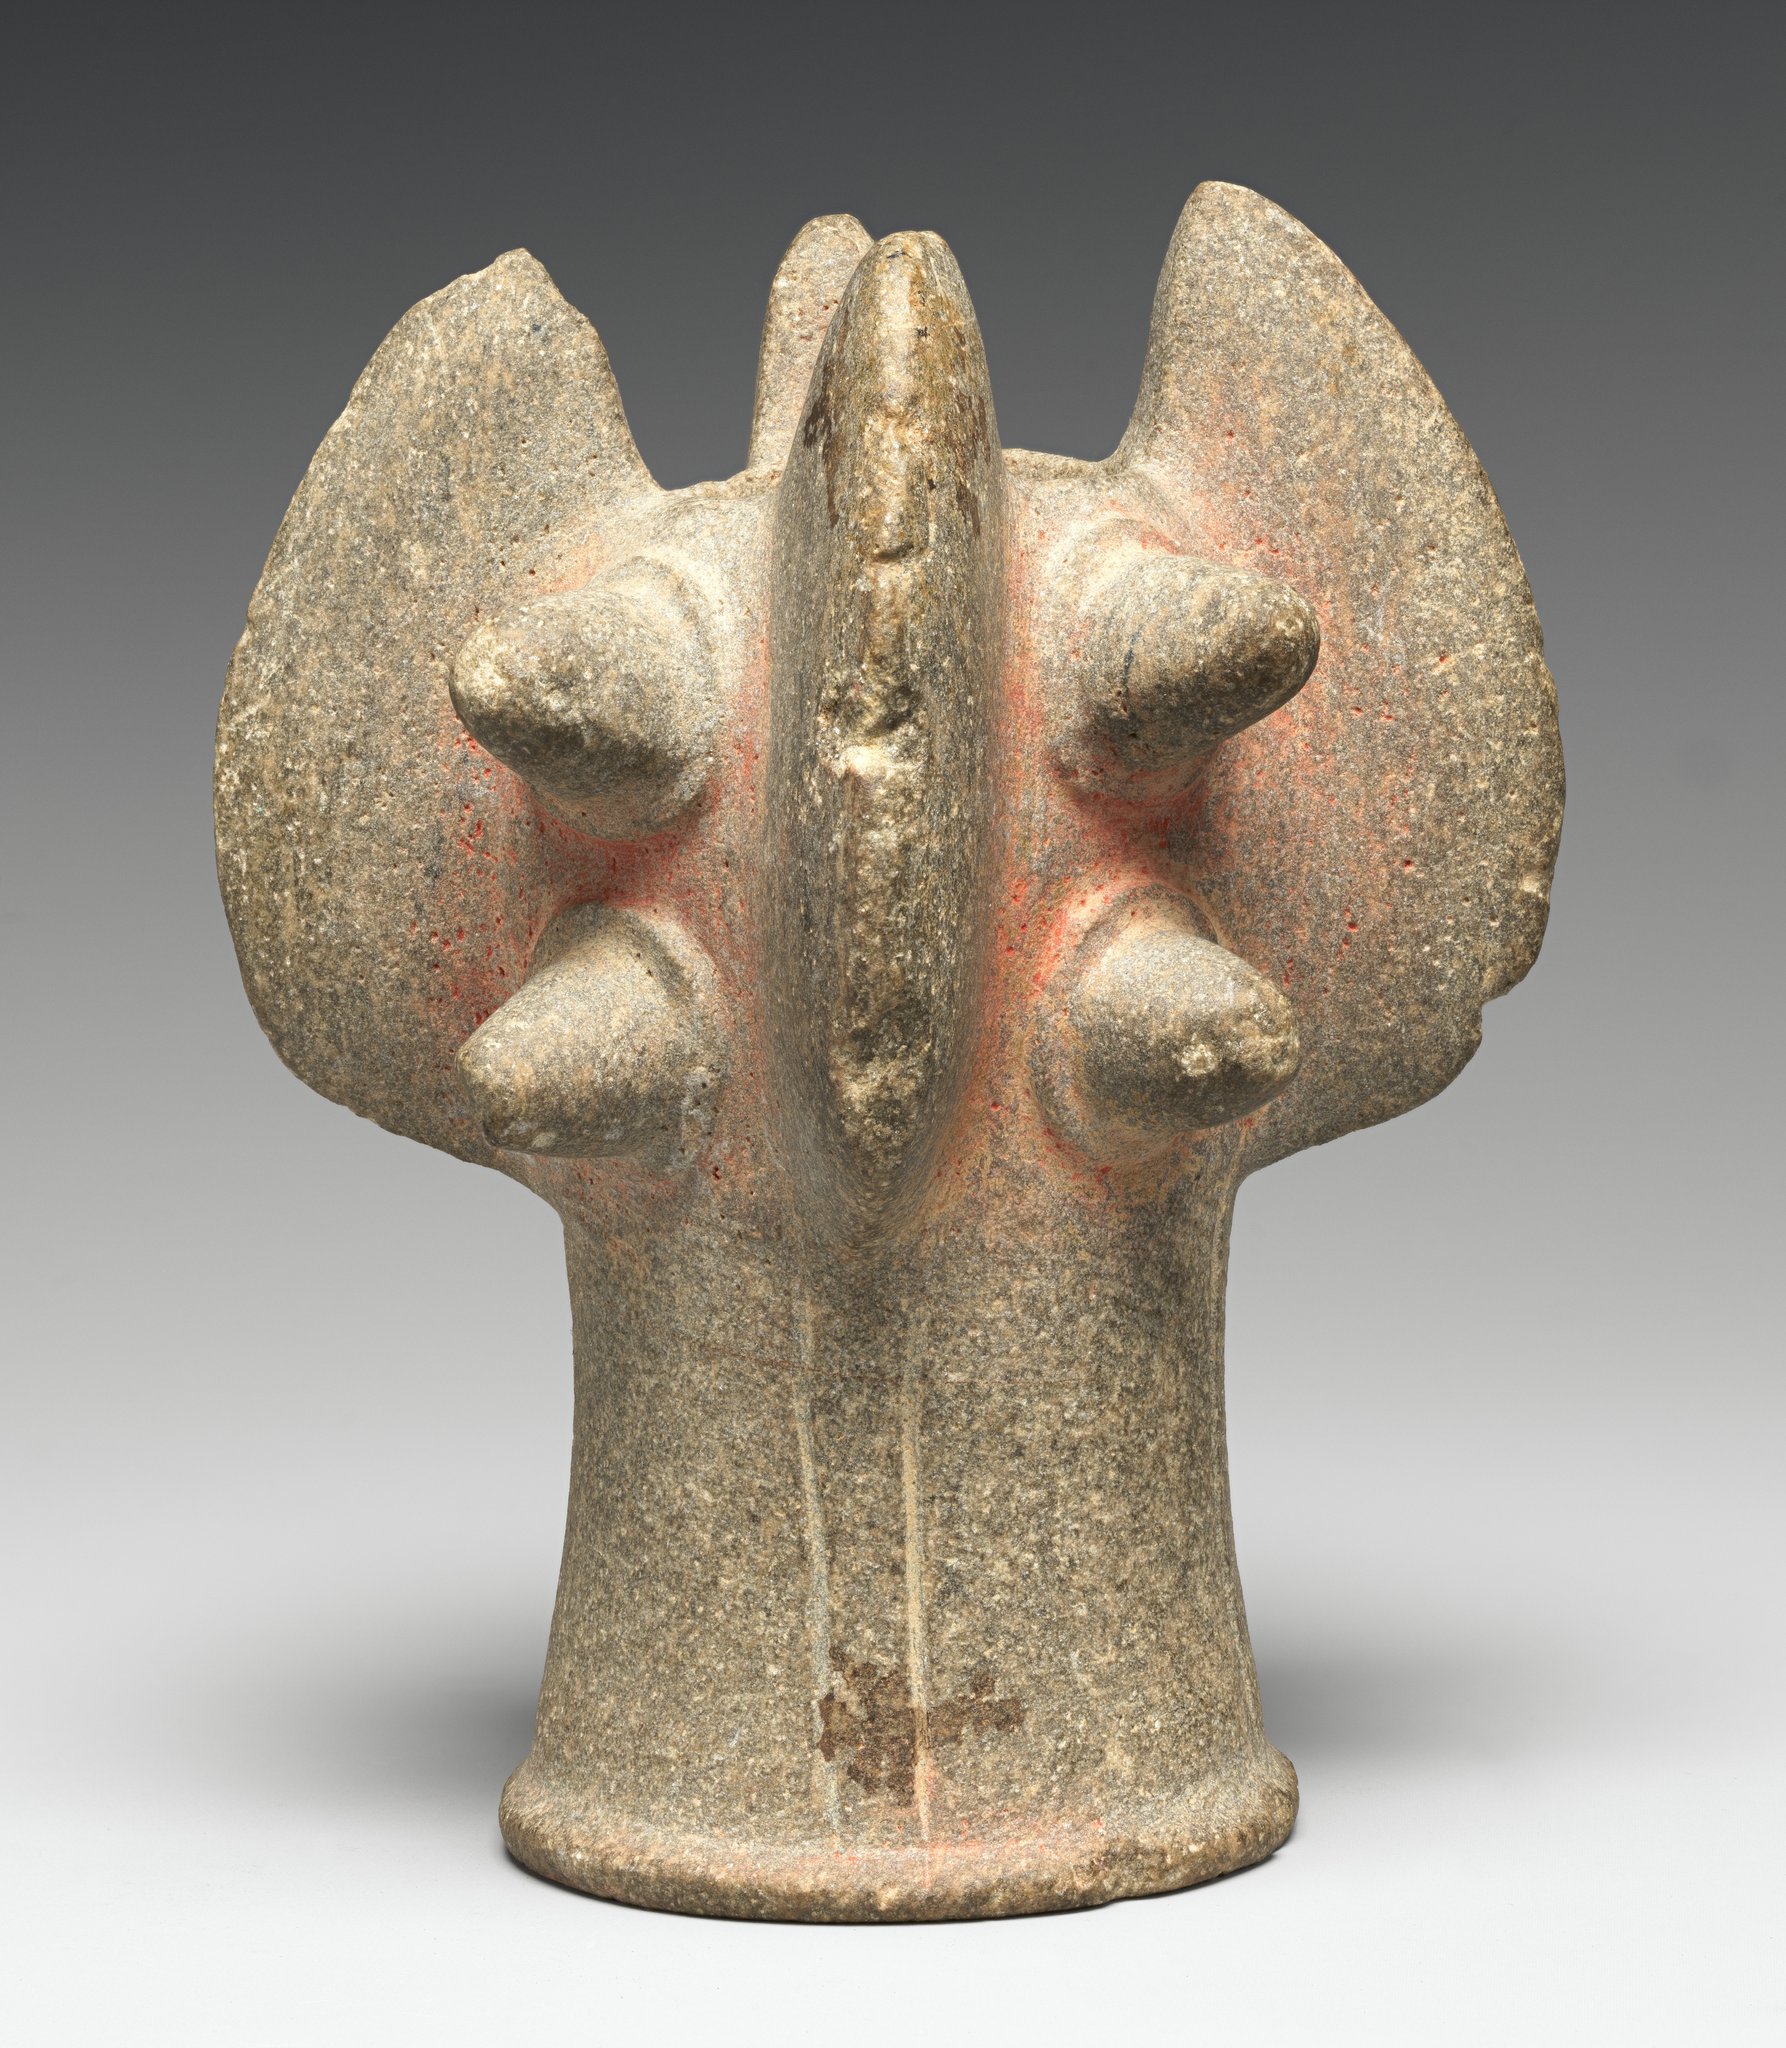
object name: mace head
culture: salinar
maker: salinar artist(s)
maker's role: artist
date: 500-100 BCE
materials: pigment, stone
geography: peru